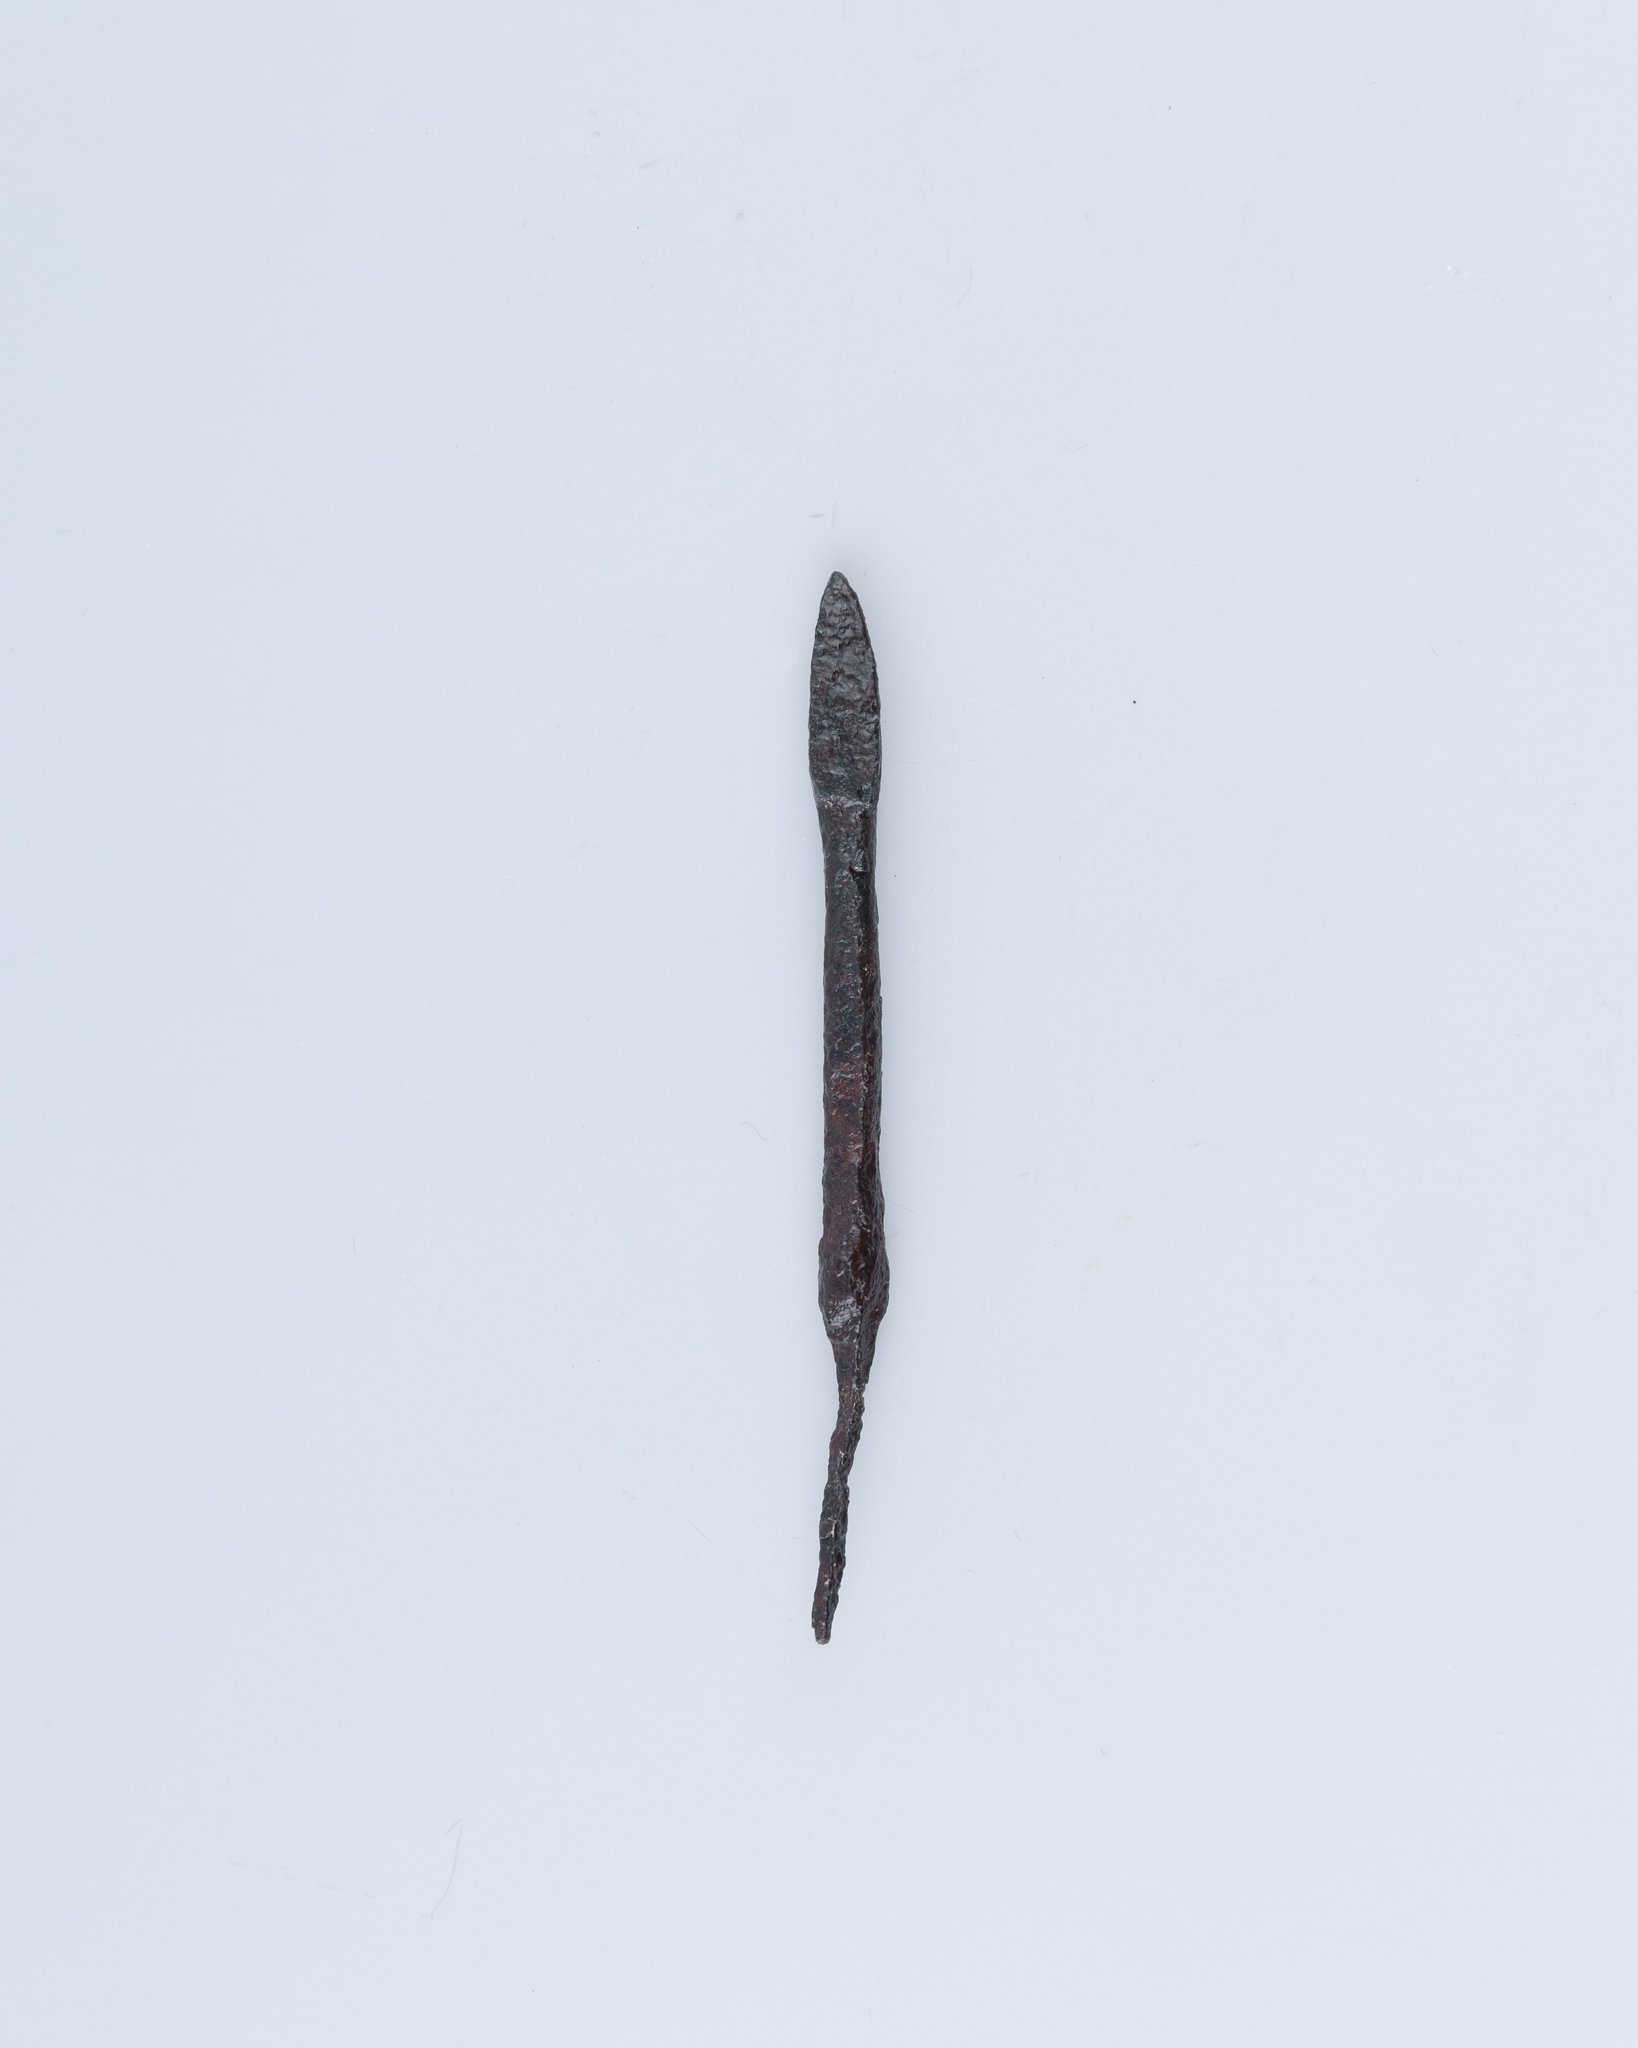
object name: arrowhead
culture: tibetan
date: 1401-1700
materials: iron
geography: tibet